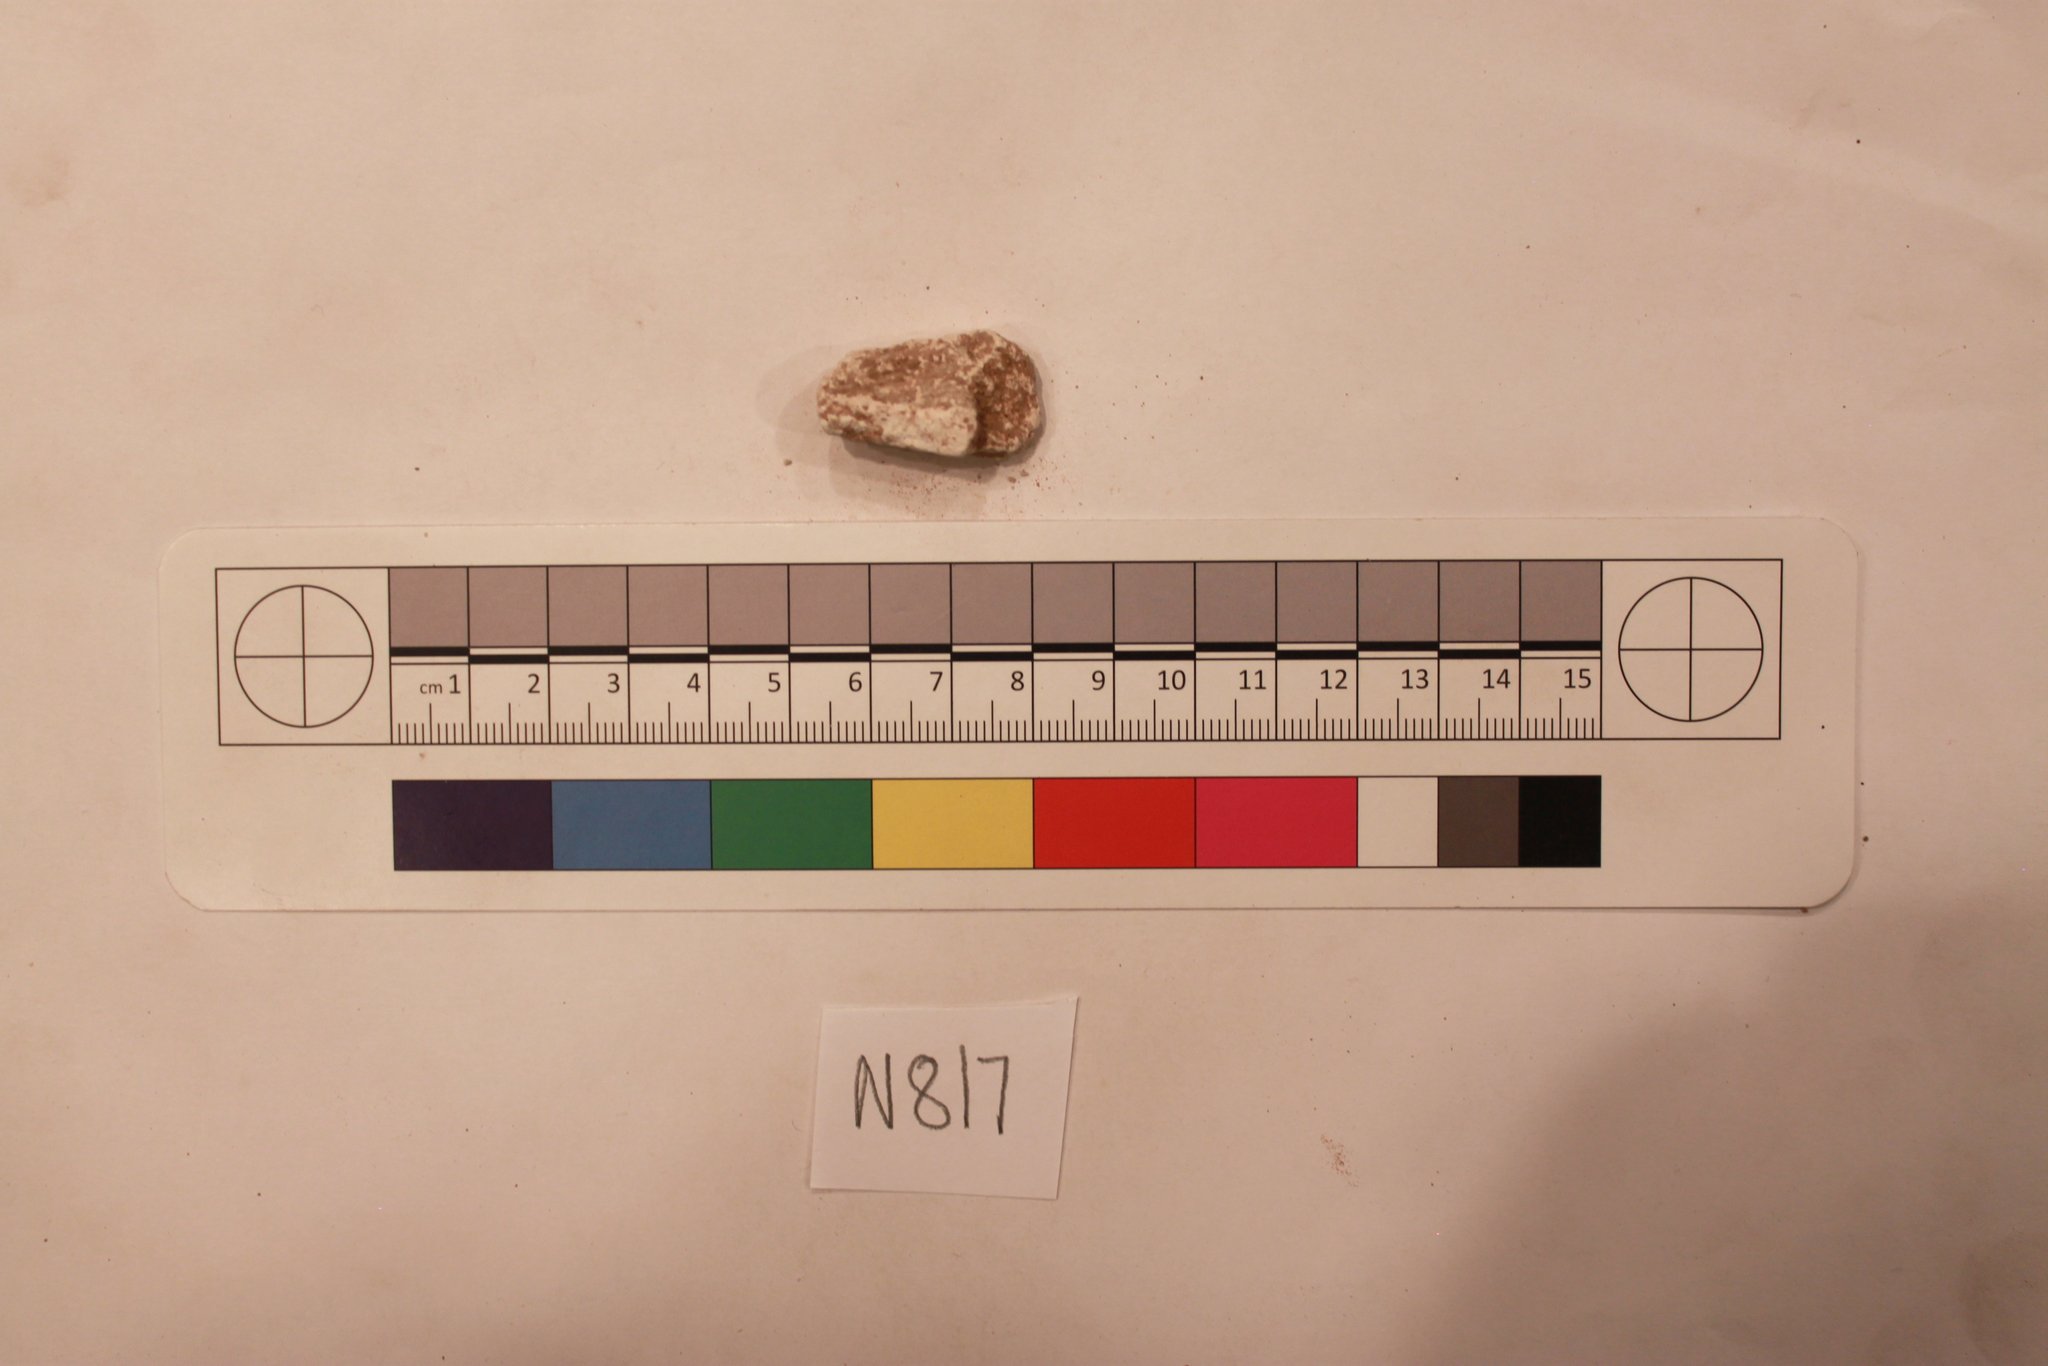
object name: fragment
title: Stucco Fragment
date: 701-1200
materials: plaster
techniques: carving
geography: iran